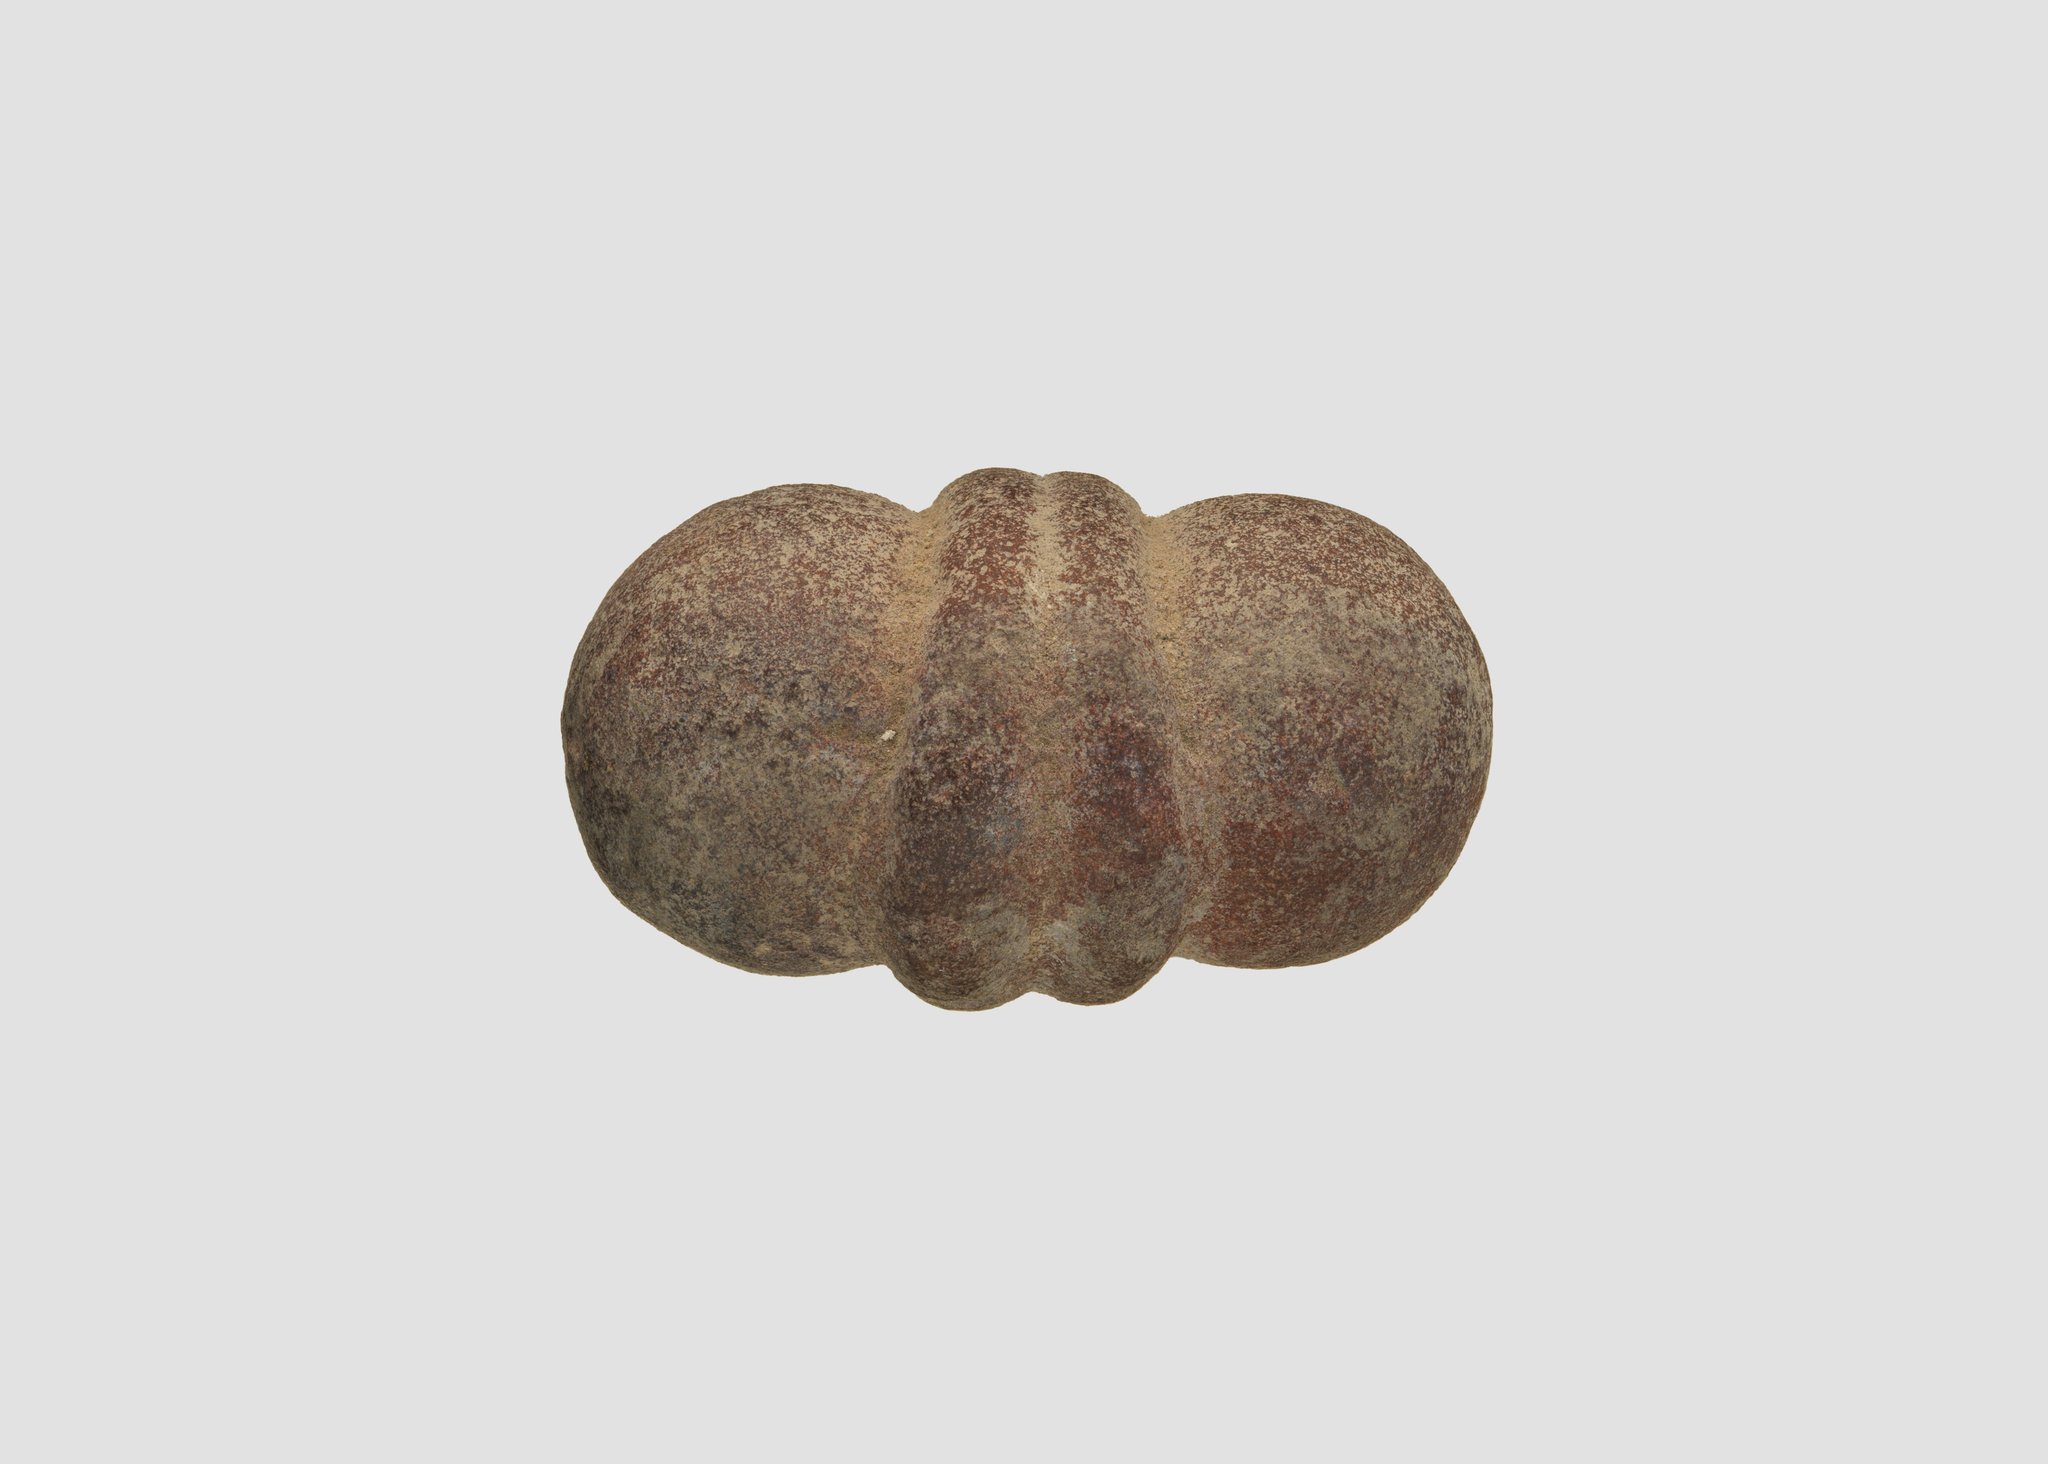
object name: object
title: Unidentified object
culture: iranian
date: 900-801 BCE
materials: stone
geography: iran